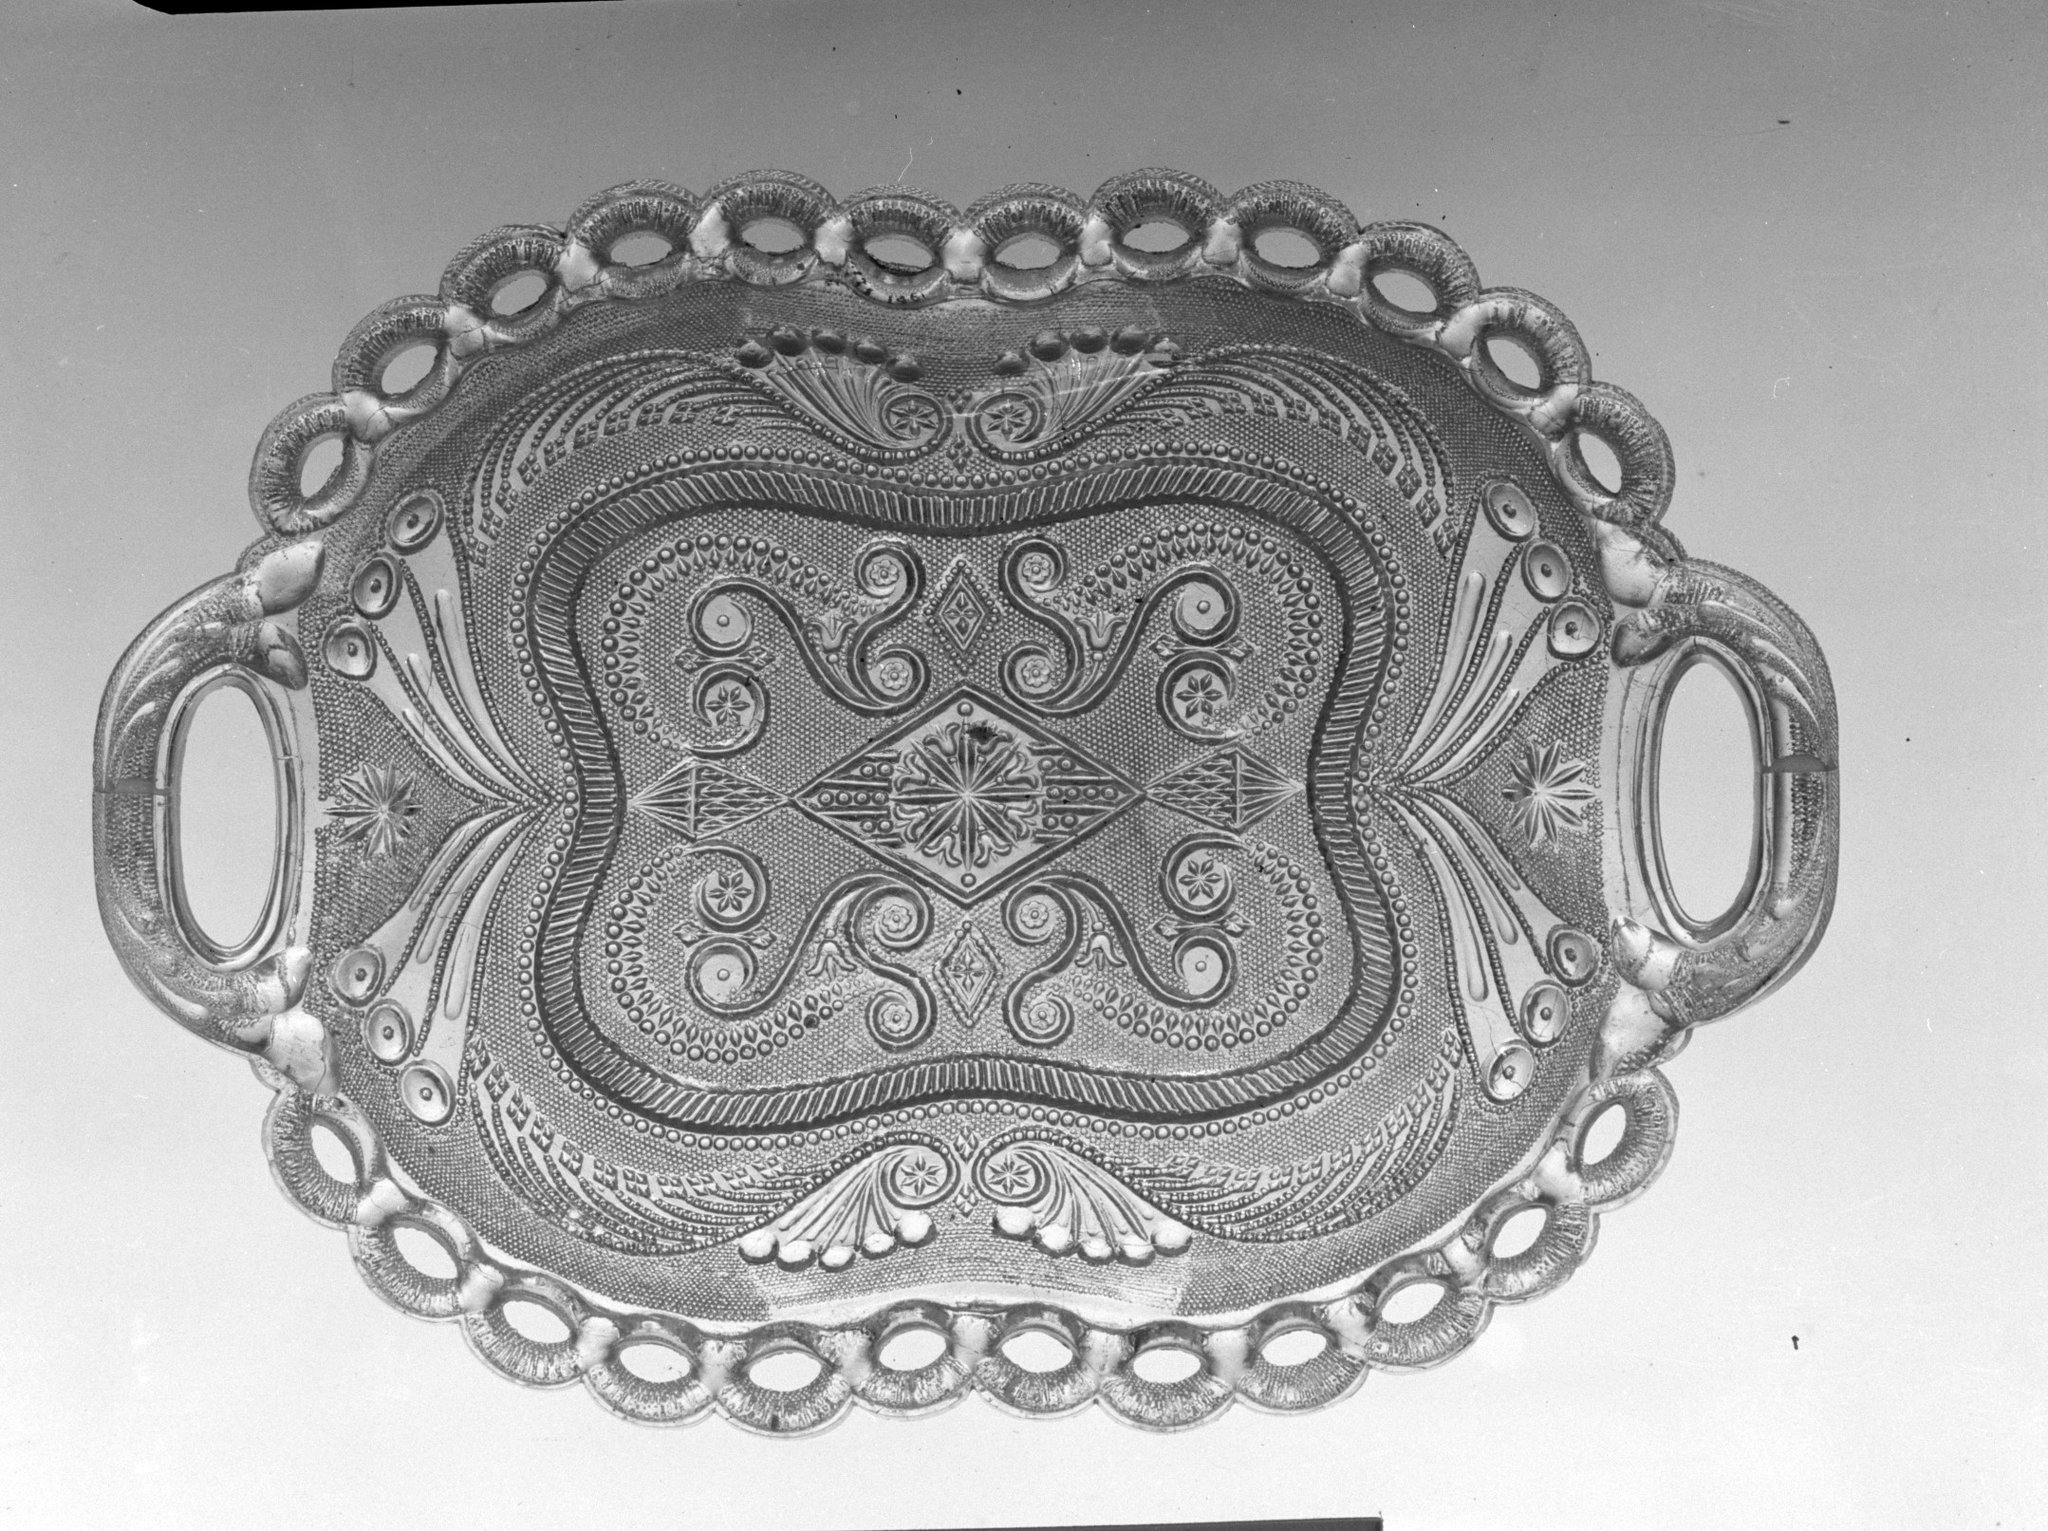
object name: cake tray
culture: american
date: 1830-1835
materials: glass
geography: united states